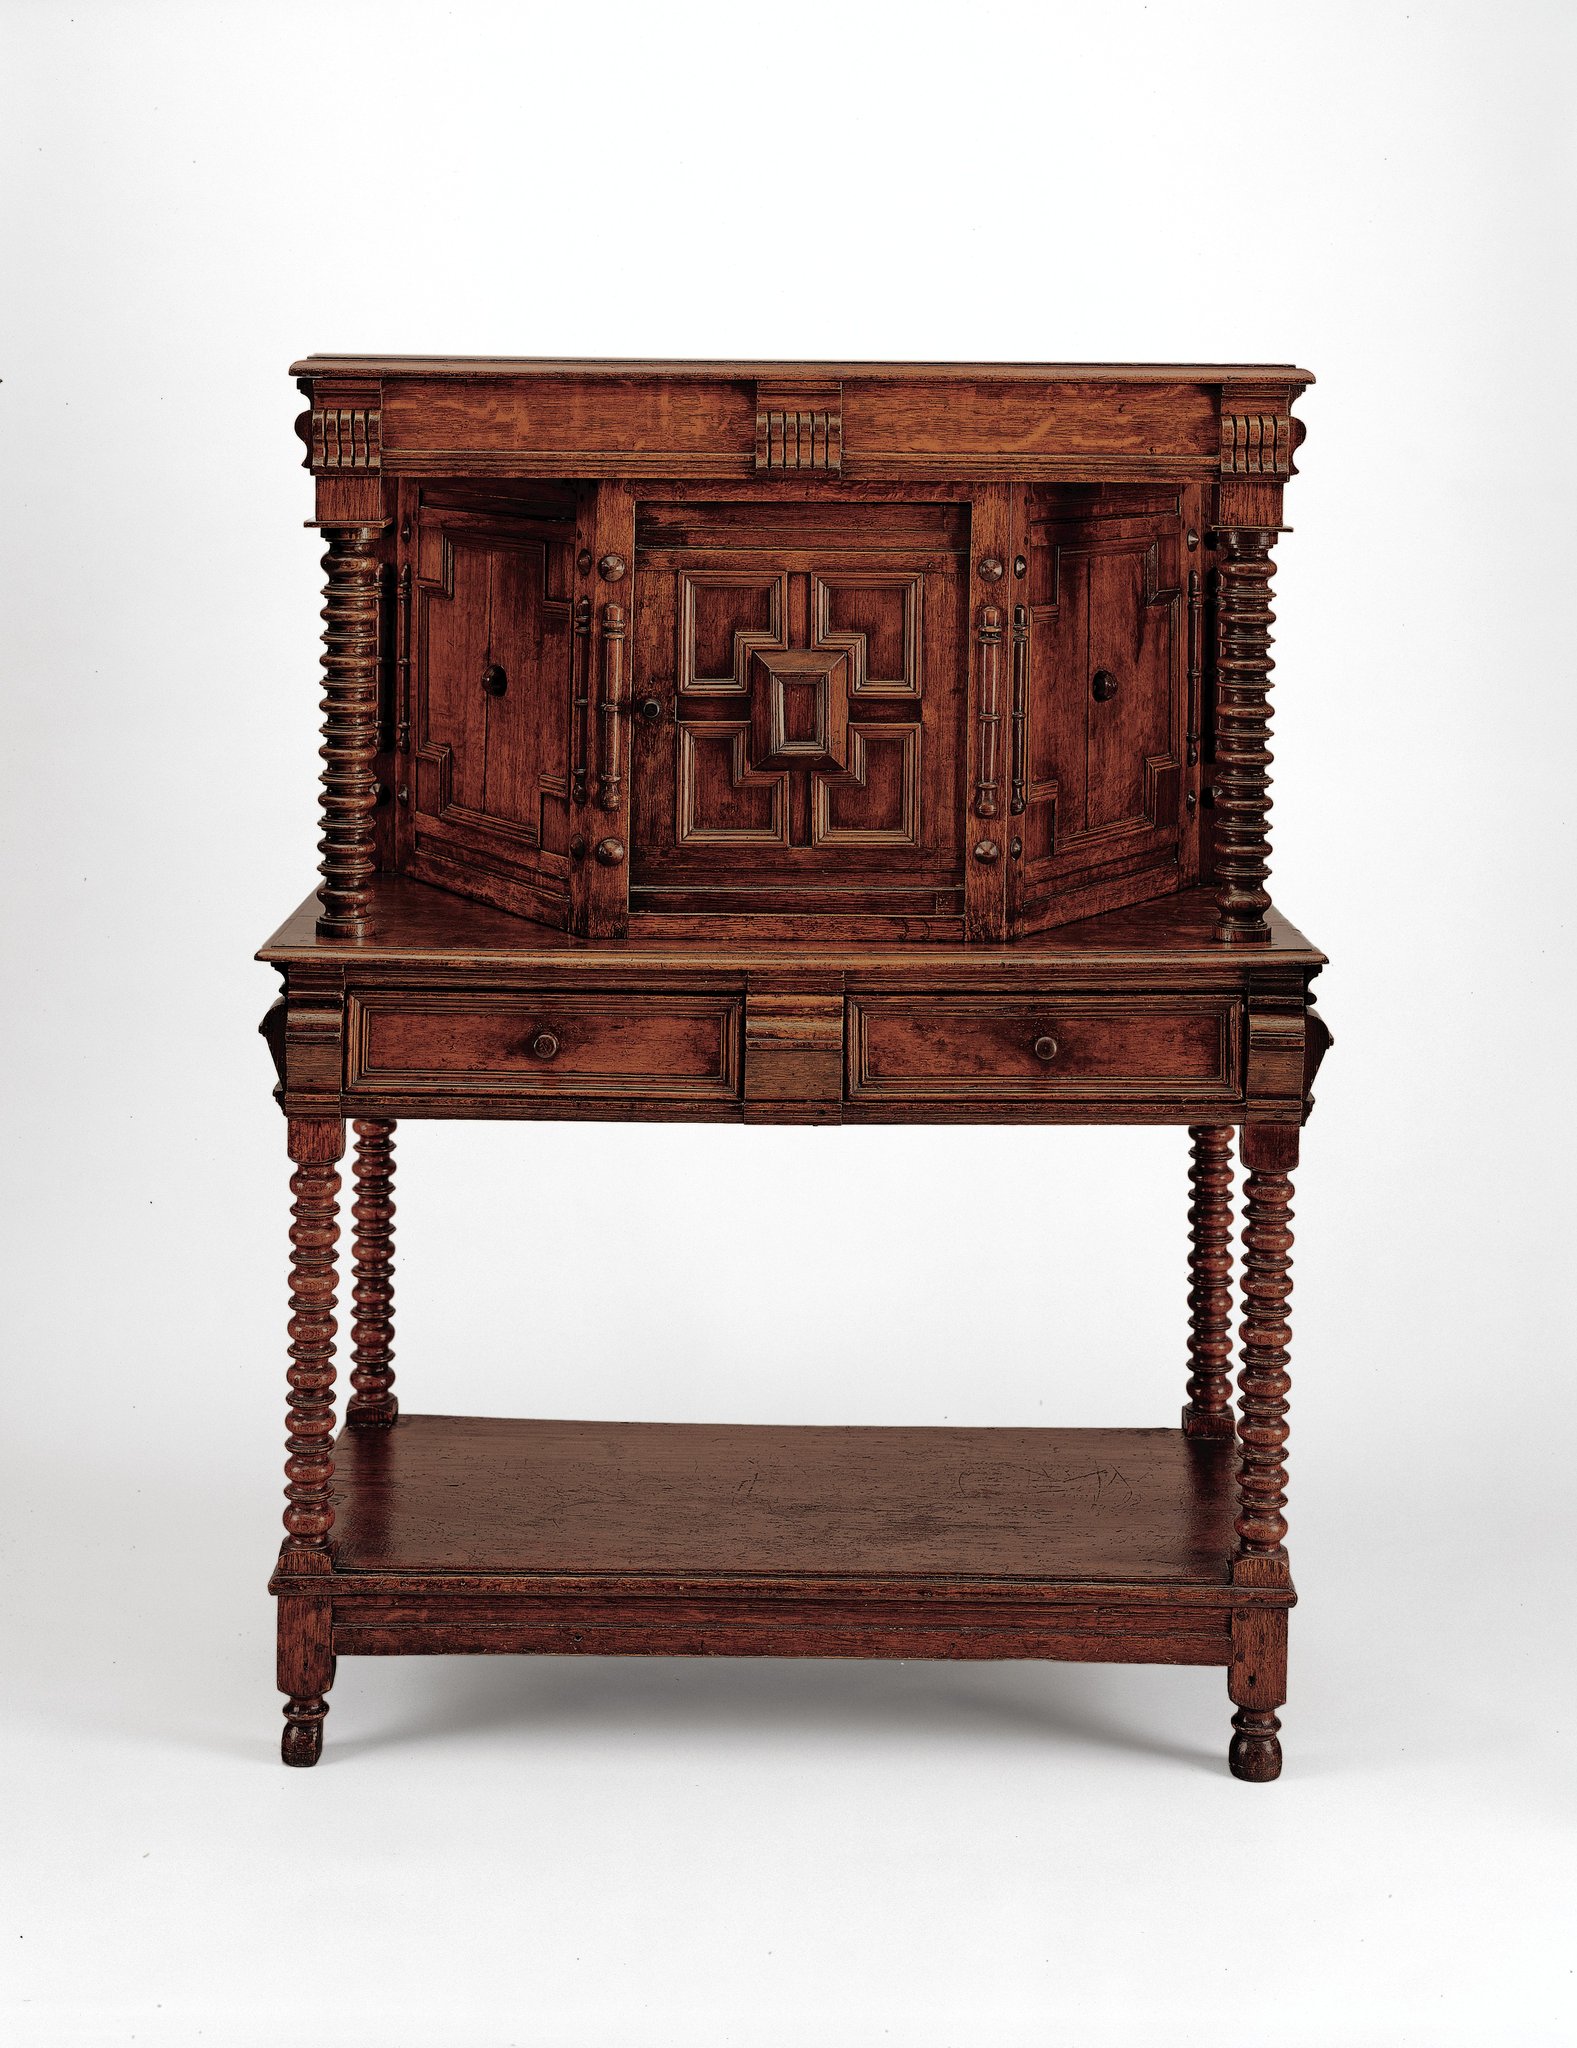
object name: cupboard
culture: american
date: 1670-1700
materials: wood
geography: united states